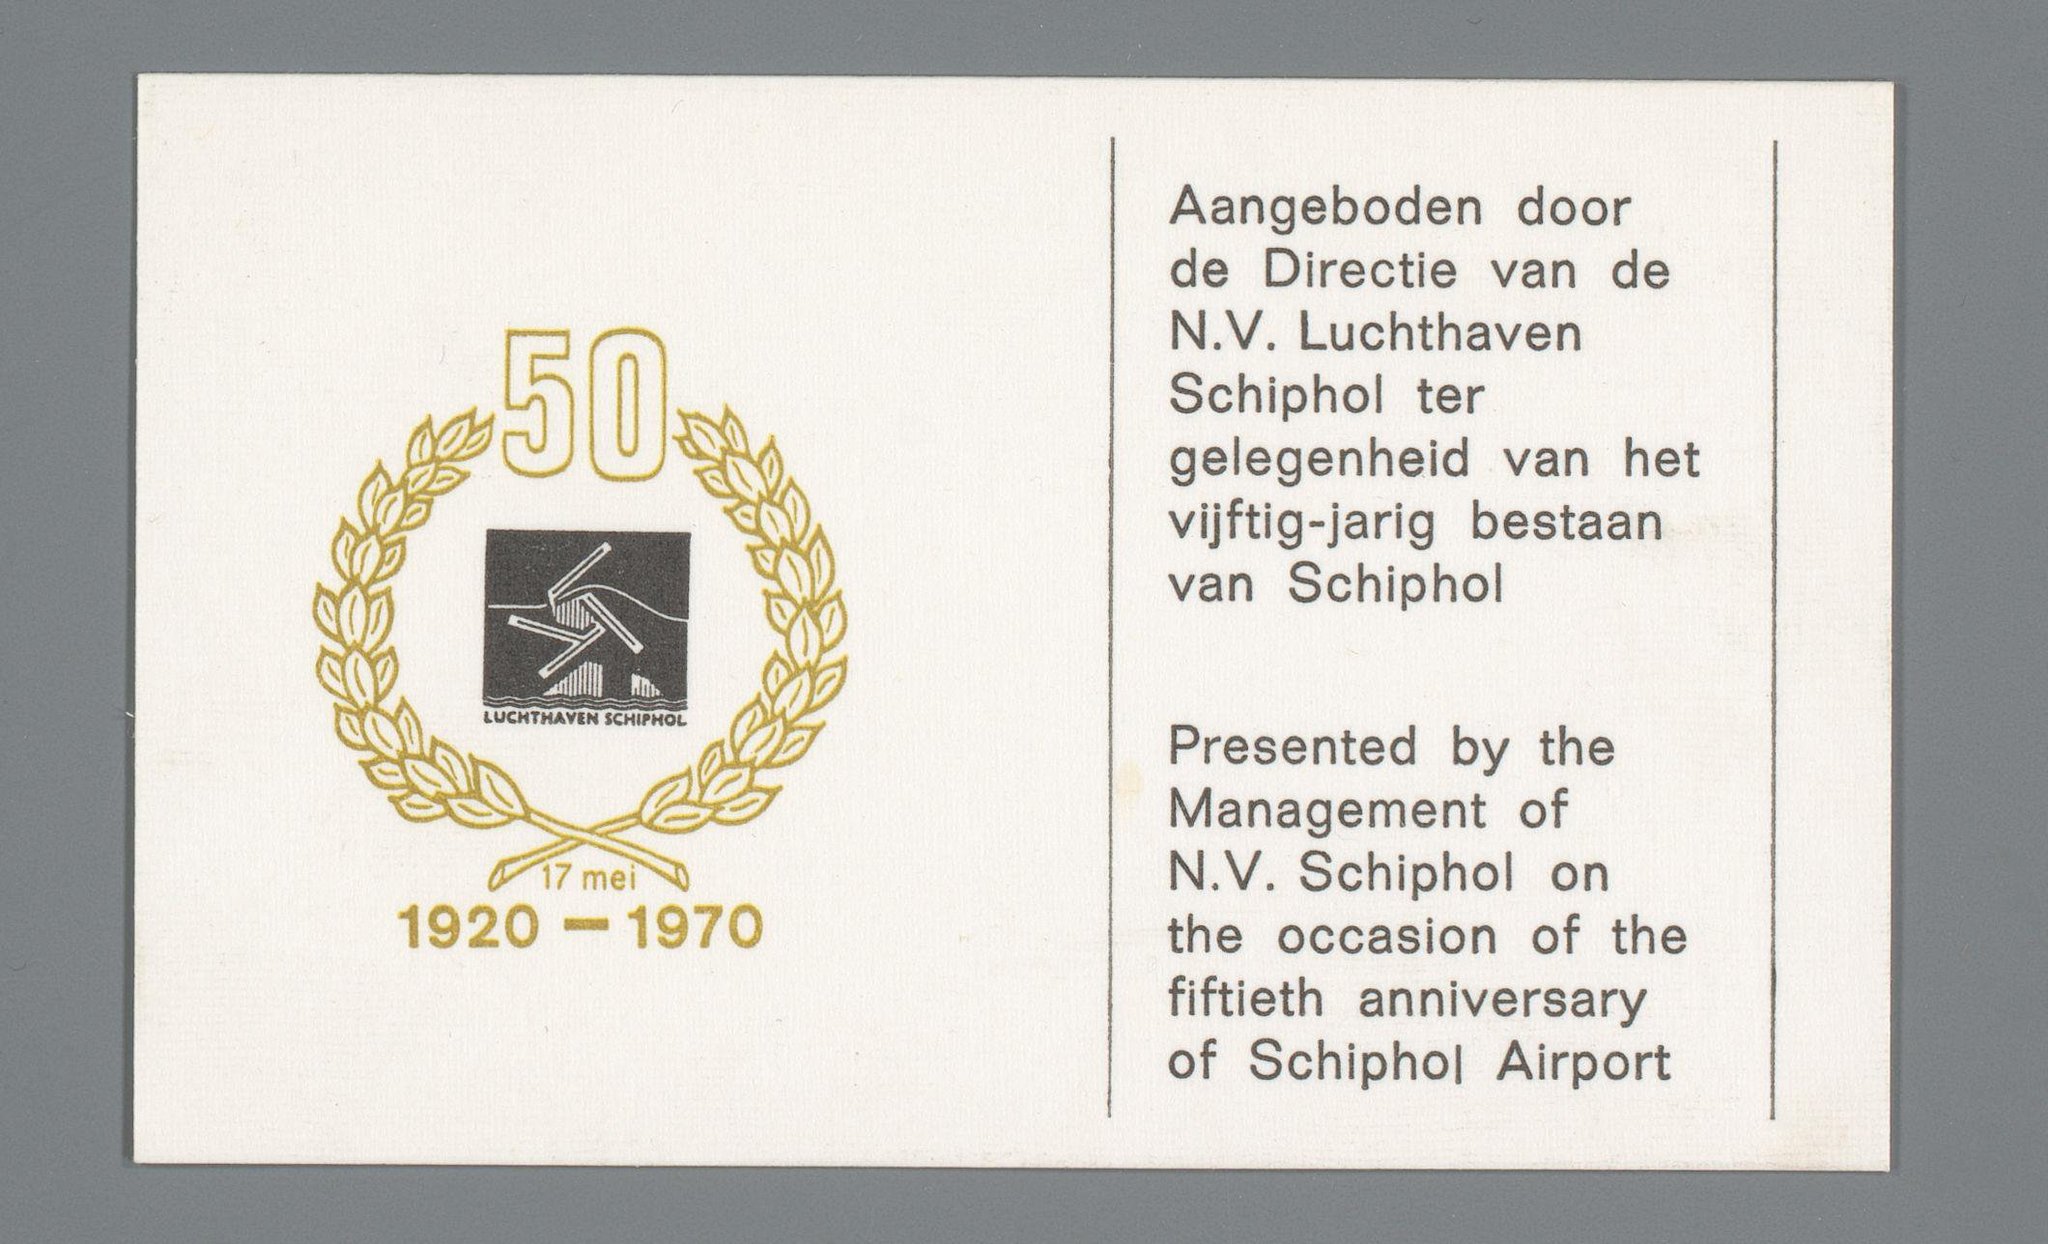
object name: photomechanical print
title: Kaart ter attentie van het 50-jarige bestaan van luchthaven Schiphol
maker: Anonymous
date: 1970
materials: paper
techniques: letterpress printing, printing block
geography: netherlands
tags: schiphol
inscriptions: inscription: ‘Aangeboden door/ de Directie van de/ N.V. Luchthaven/ Schiphol ter/ gelegenheid van het/ vijftig-jarig bestaan/ van Schiphol/ (...)’